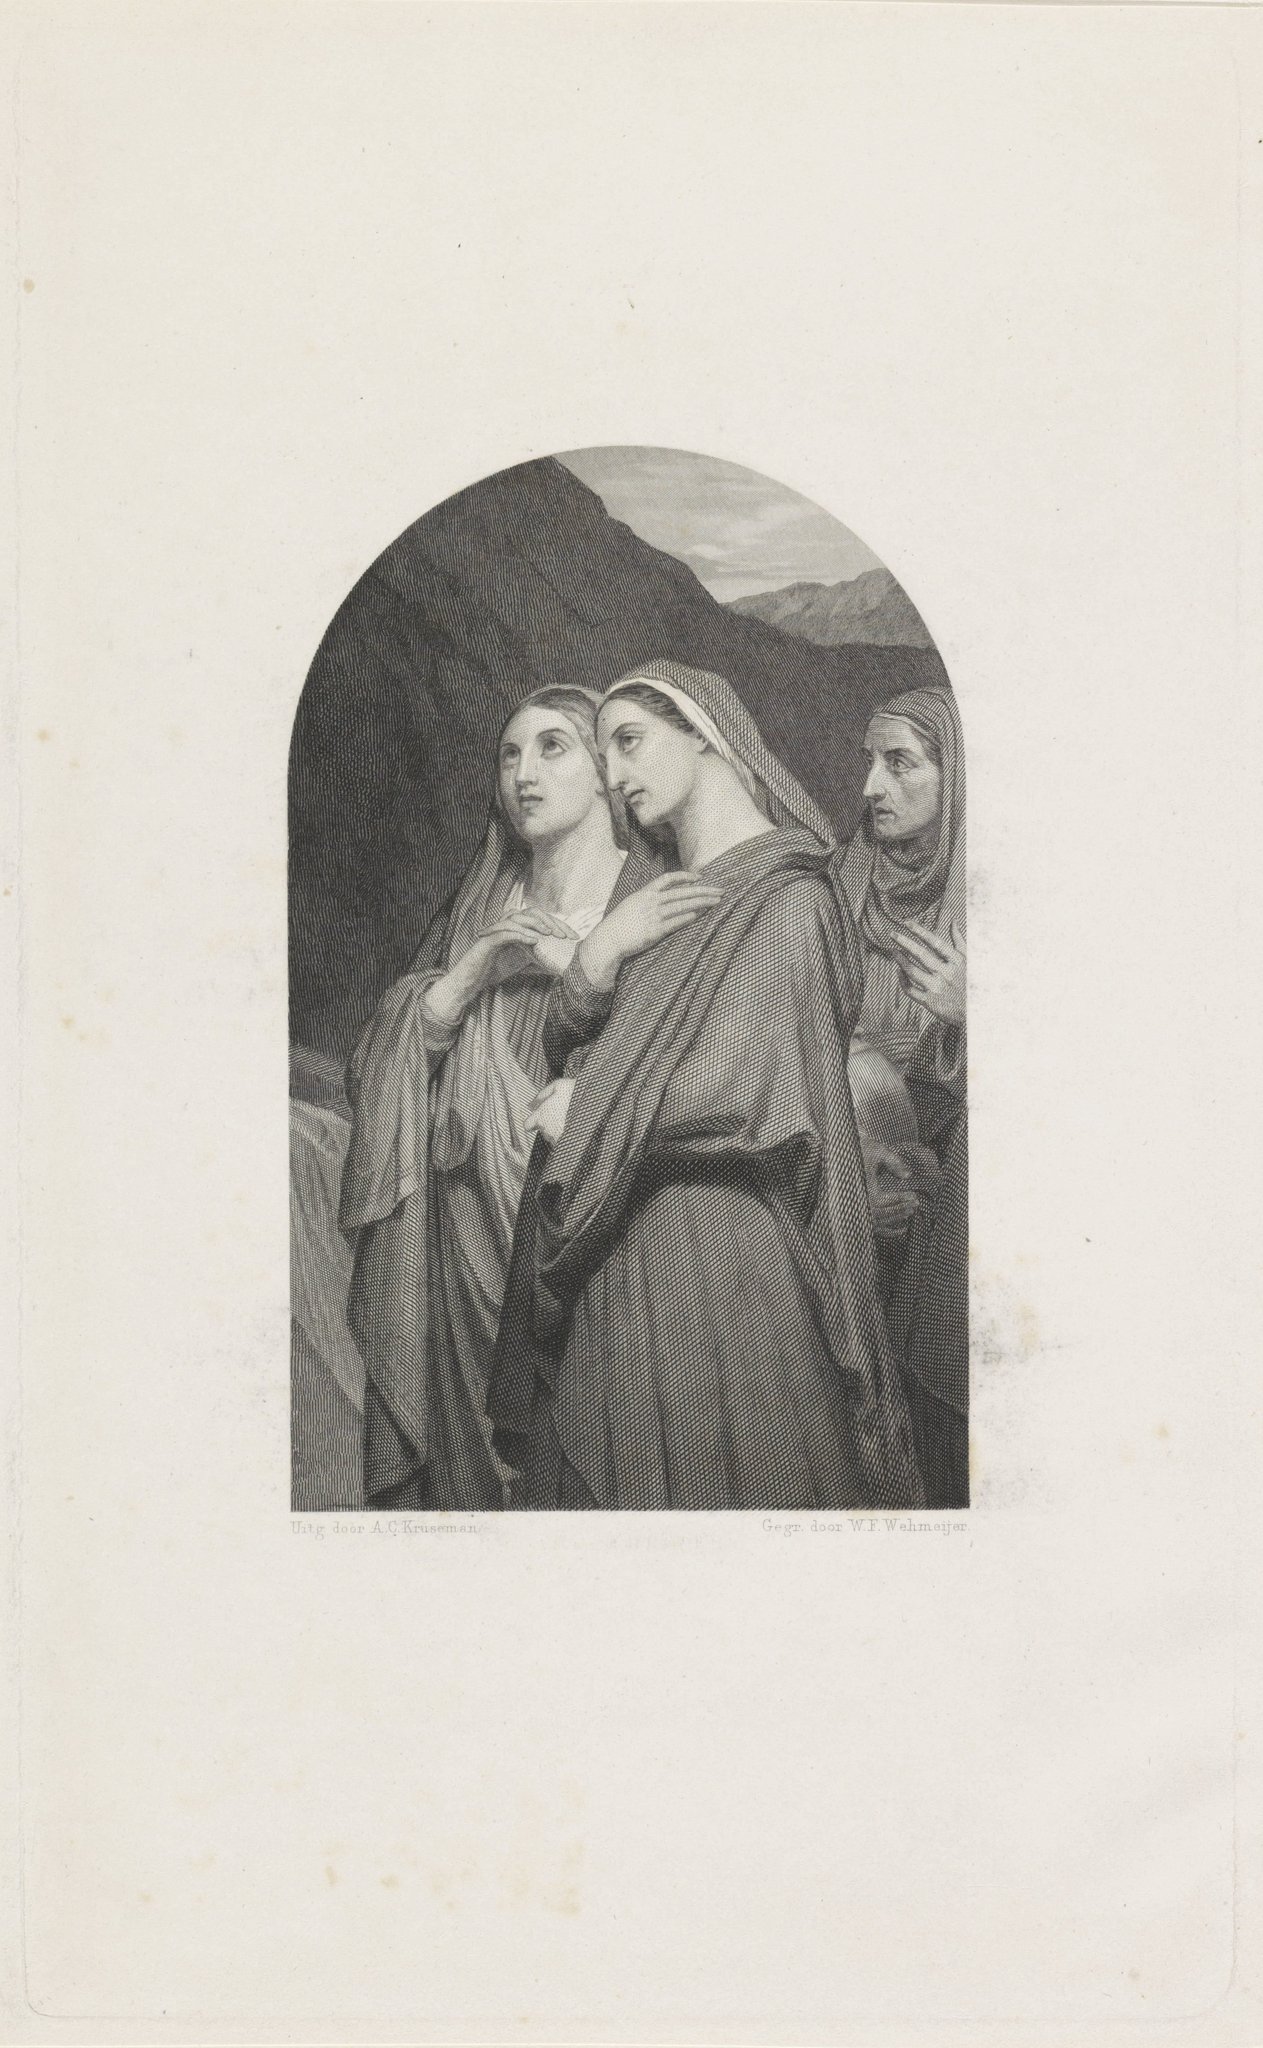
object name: print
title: Rouwende vrouwen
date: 1842-1873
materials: paper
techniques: engraving, roulette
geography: haarlem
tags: adult woman, mourning customs, crying, shouting, urn, container of ceramics: jar, jug, pot, vase, mountains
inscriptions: collector's mark: Lugt 2228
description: Twee jonge en een oudere vrouw zijn in een berglandschap weergegeven. Ze dragen een japon en een omslagdoek. De linkervrouw heeft haar handen gevouwen en huilt. De oudere vrouw houdt een kruik of urn vast.